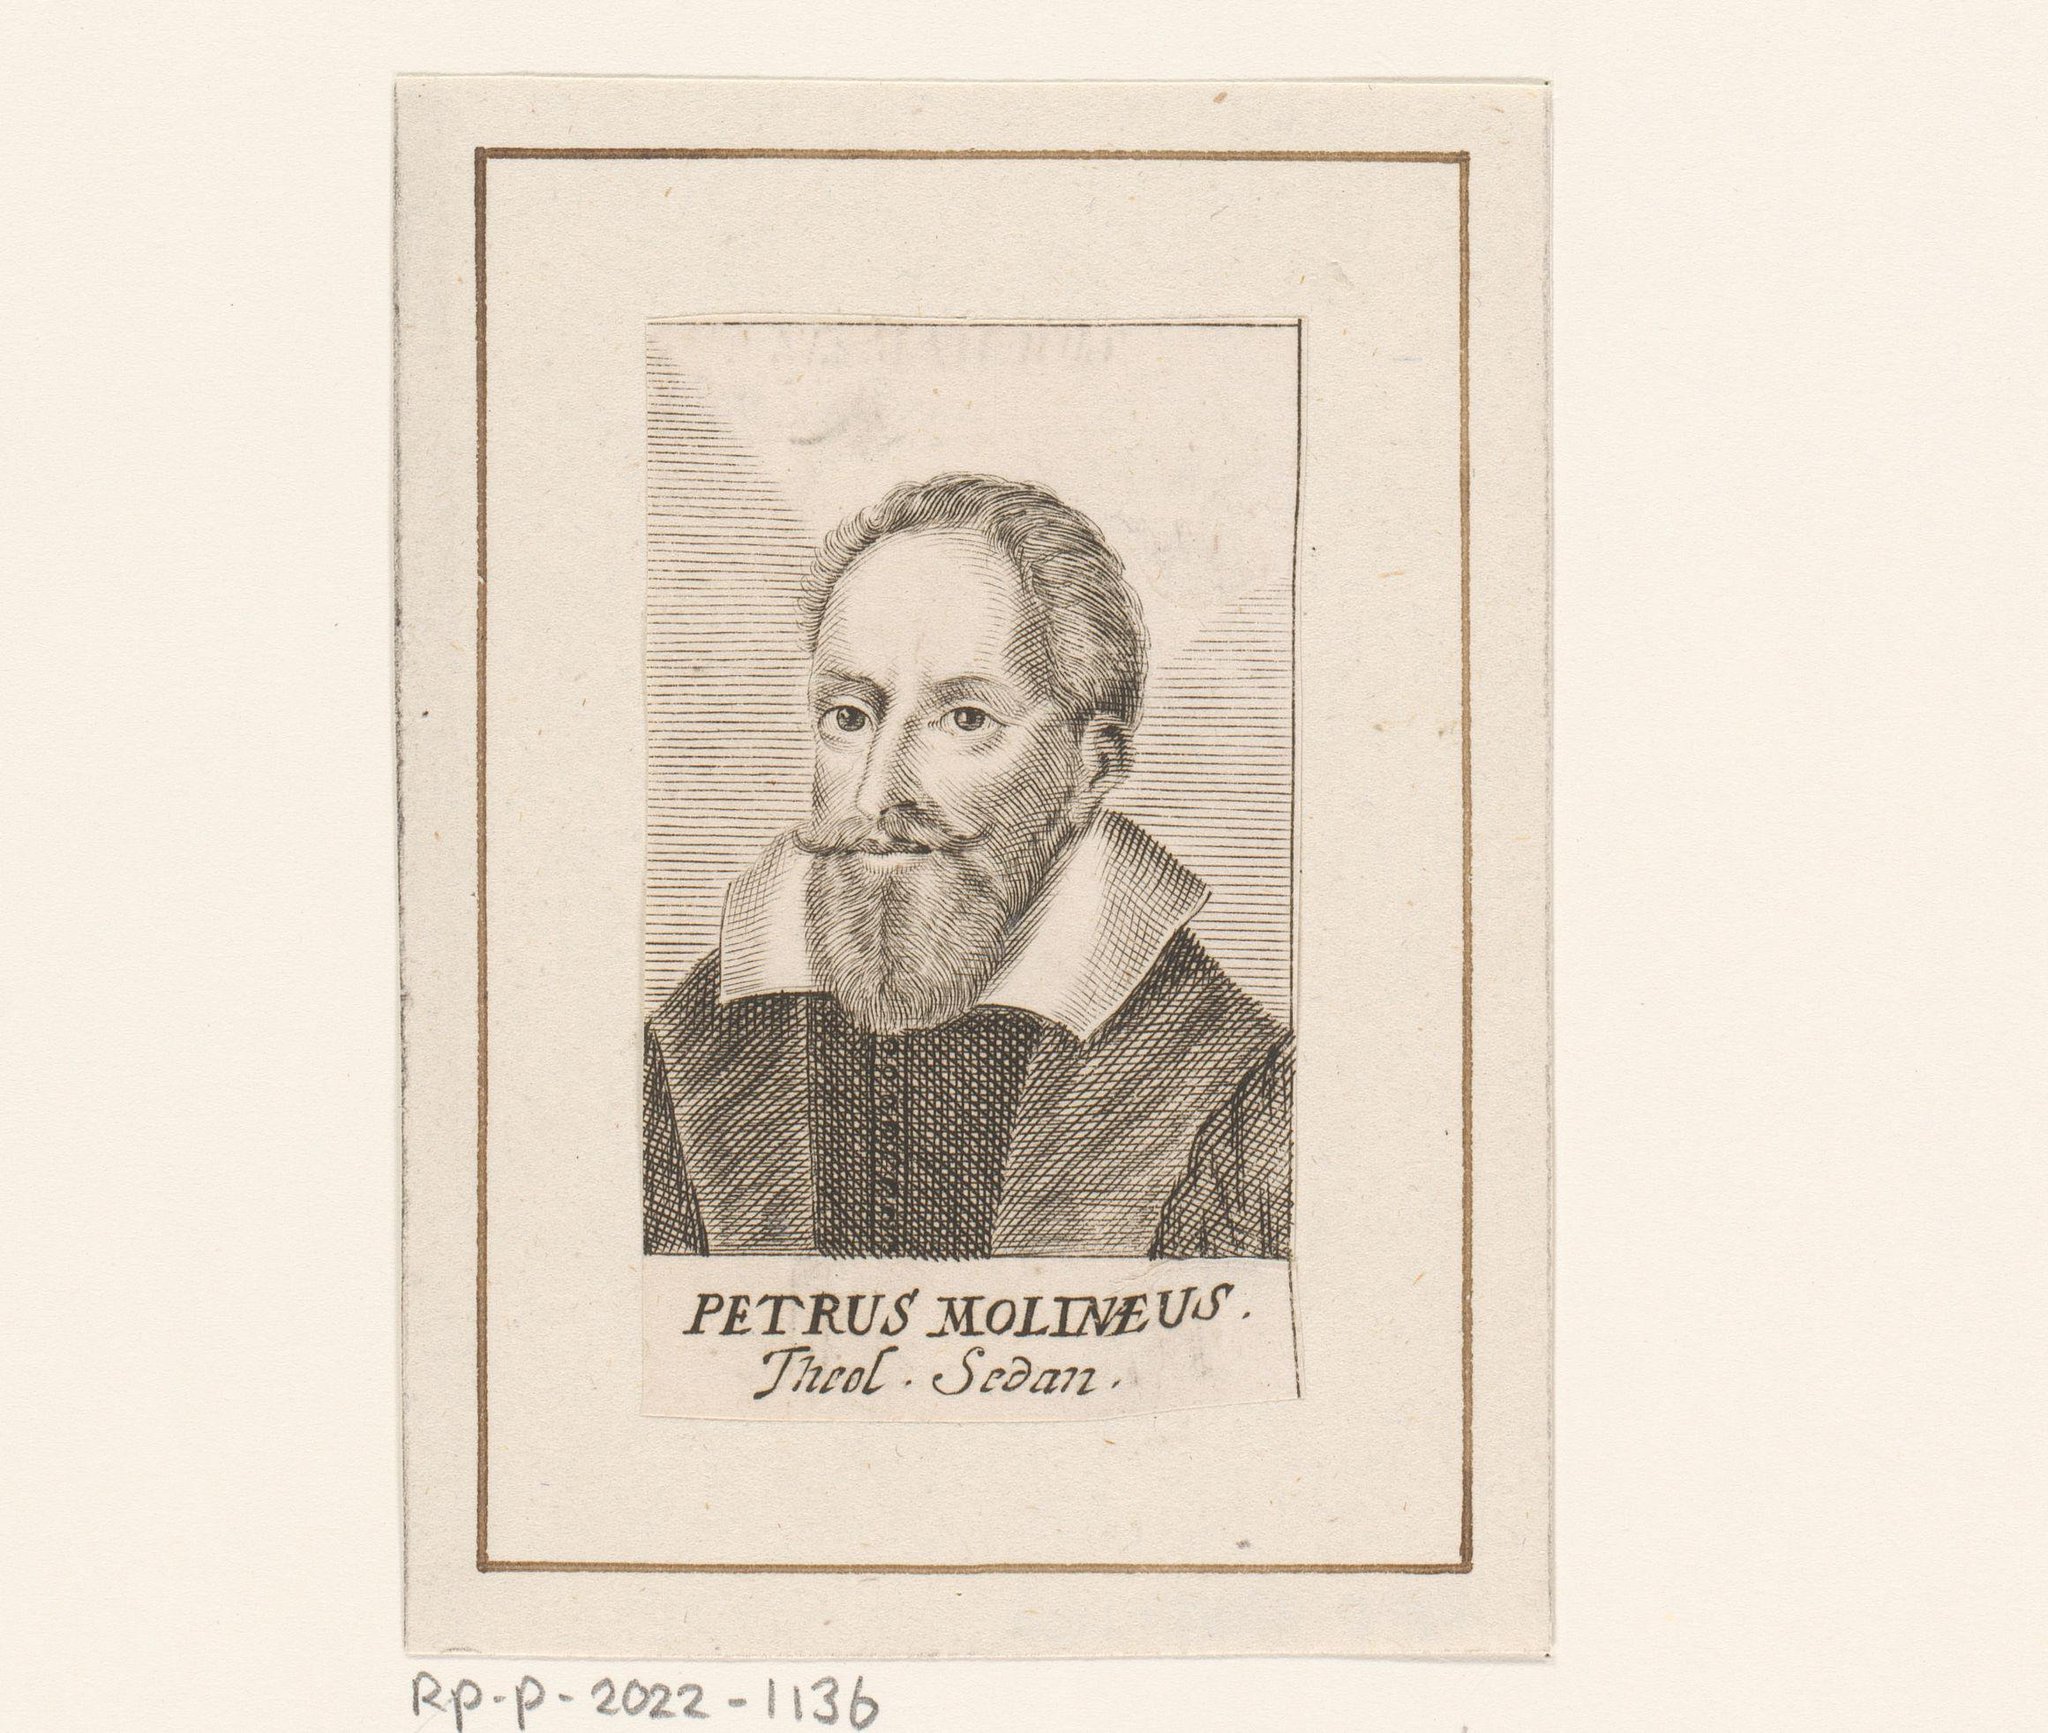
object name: print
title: Petrus Molinaeus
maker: Anonymous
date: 1688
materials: paper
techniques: engraving, snipping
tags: minister ~ government, historical persons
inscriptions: collector's mark: Lugt 2228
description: Prent waarschijnlijk uit: Freher, Paul. Theatrum virorum eruditione clarorum. Neurenberg: Johann Hoffmann, 1688.